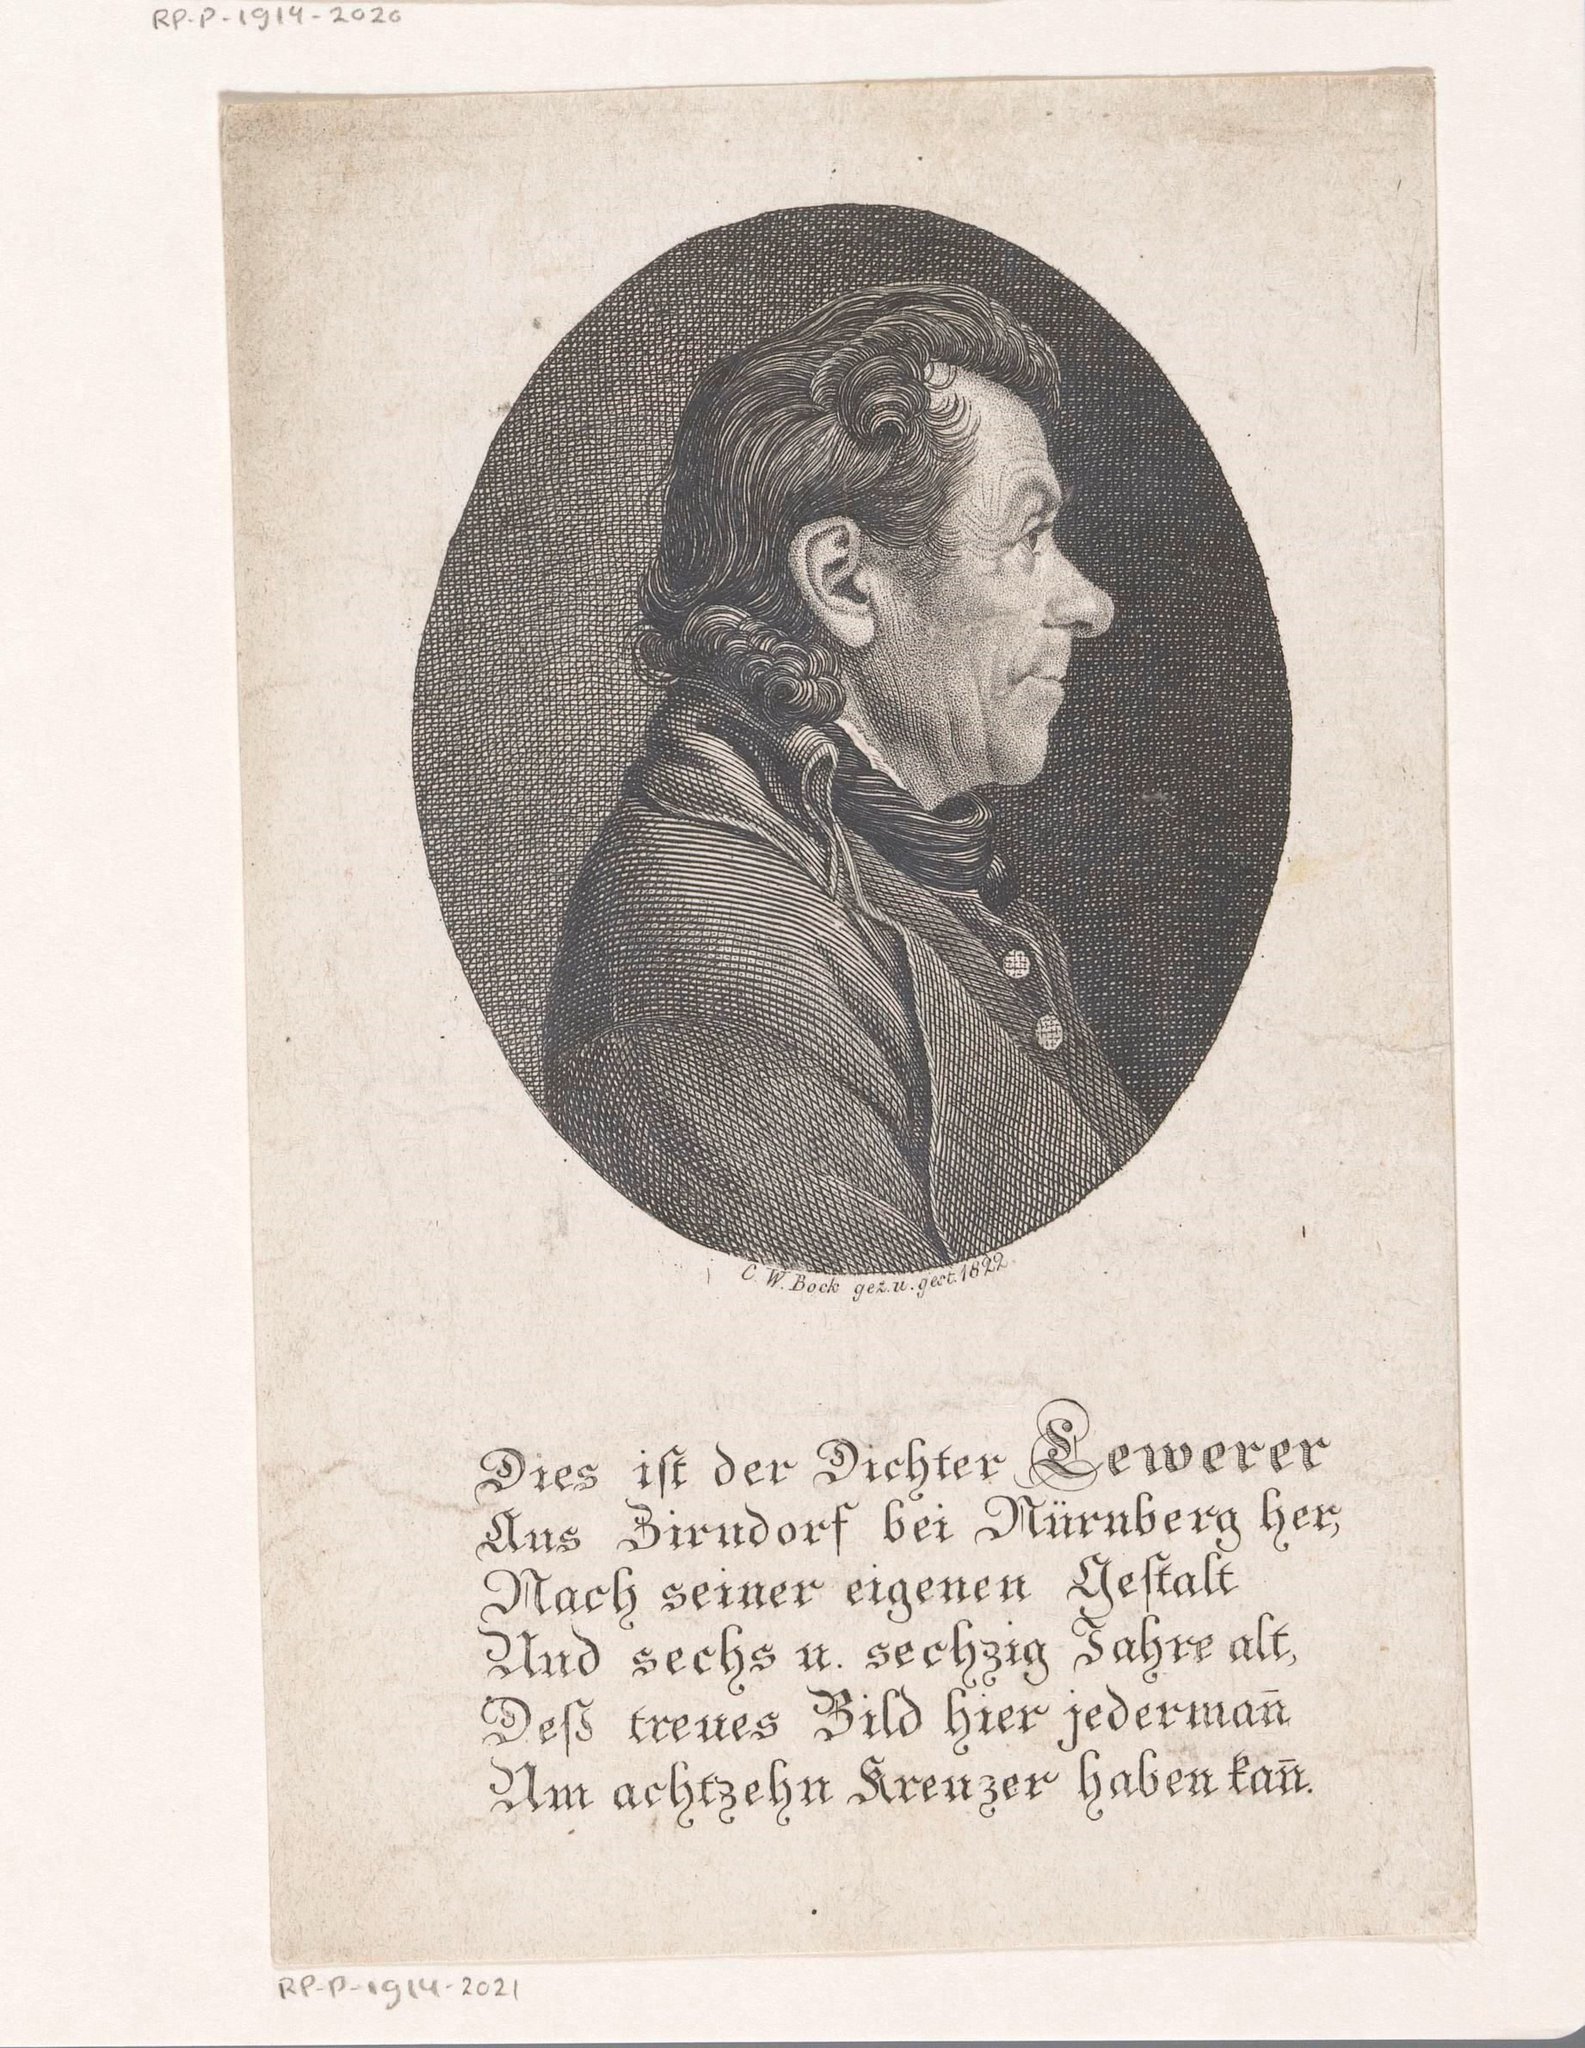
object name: print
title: Portret van Johann Jacob Lewerer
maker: christoph wilhelm bock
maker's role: print maker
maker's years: 1755-1836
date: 1822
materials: paper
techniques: engraving, etching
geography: nuremberg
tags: historical persons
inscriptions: collector's mark: Lugt 2228